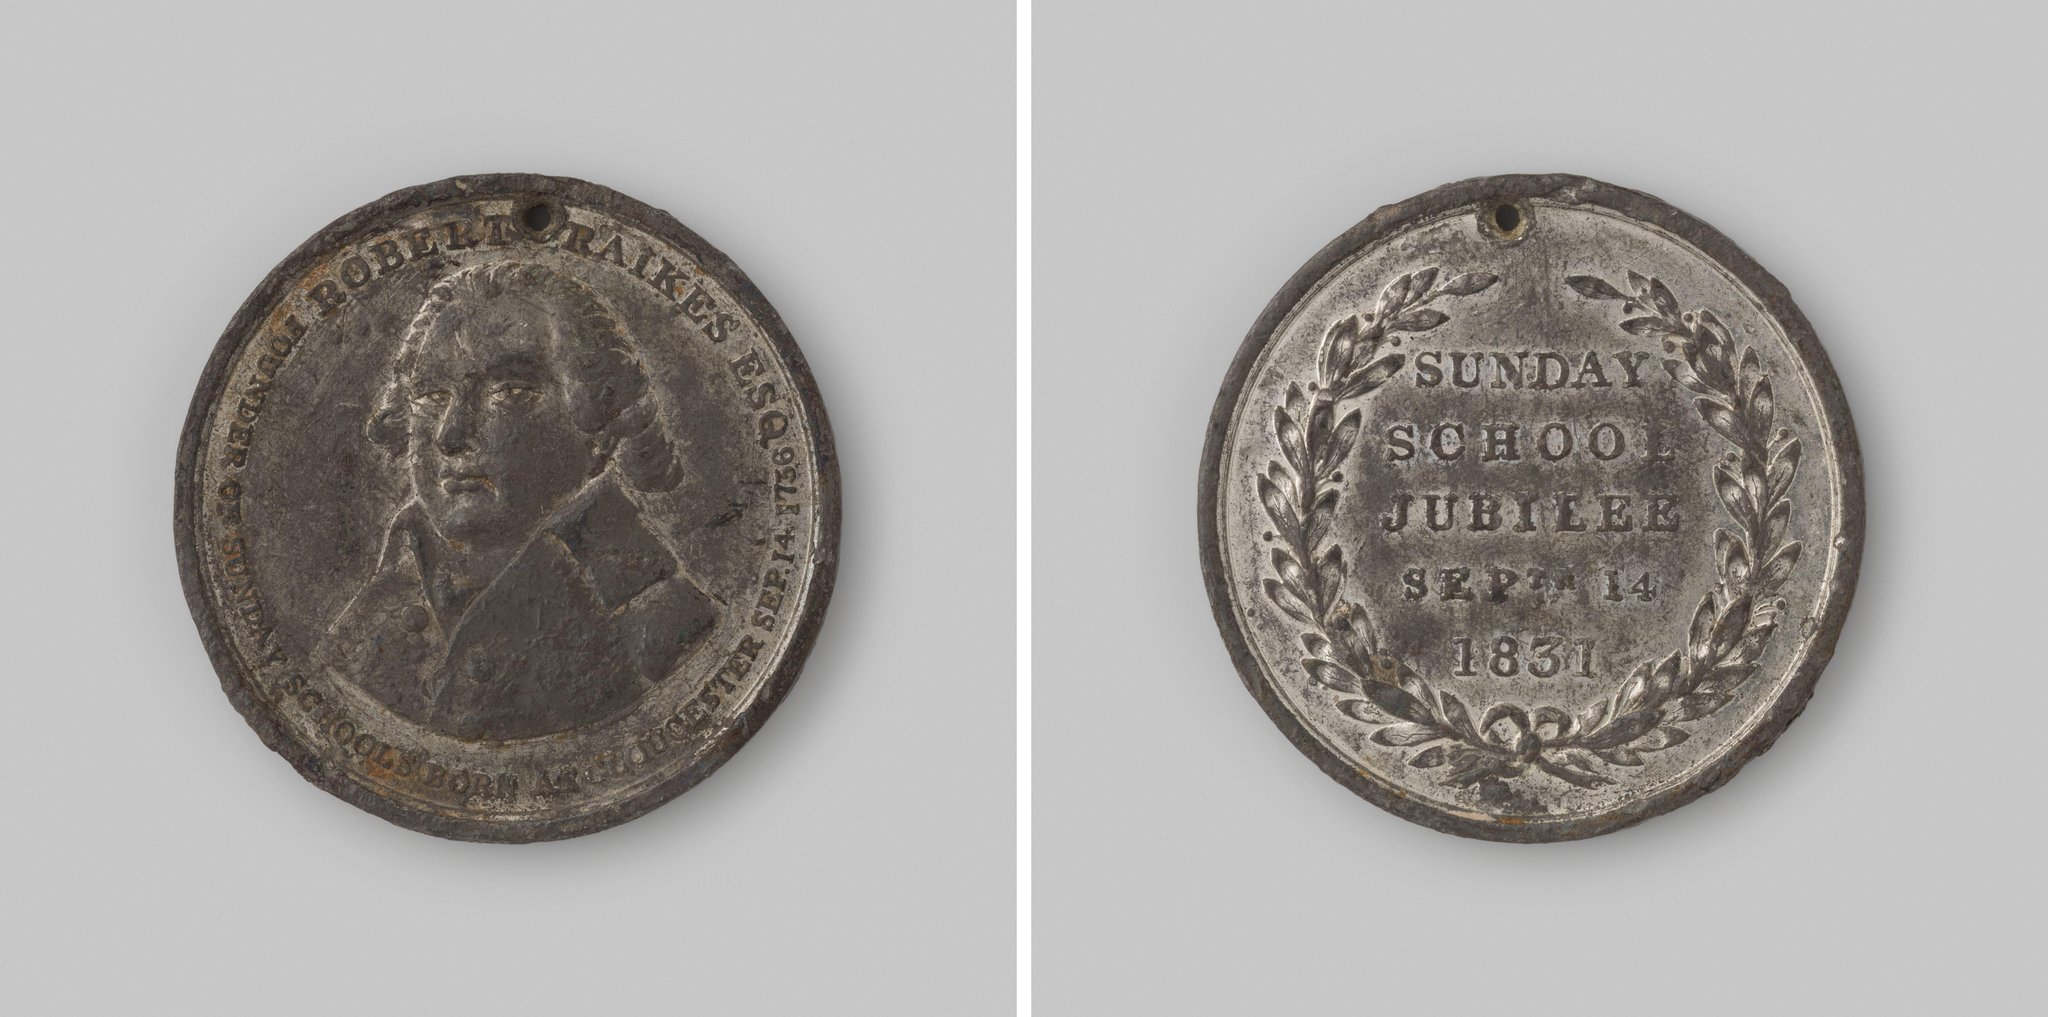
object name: history medal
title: Jubileum van de zondagscholen in Engeland 1831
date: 1831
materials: tin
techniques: striking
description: Tinnen penning met doorboring bovenin, op de voorzijde het borstbeeld van Robert Raikes half naar links met omschrift, op de keerzijde vijf regels tekst tussen samengestrikte lauwertakken.